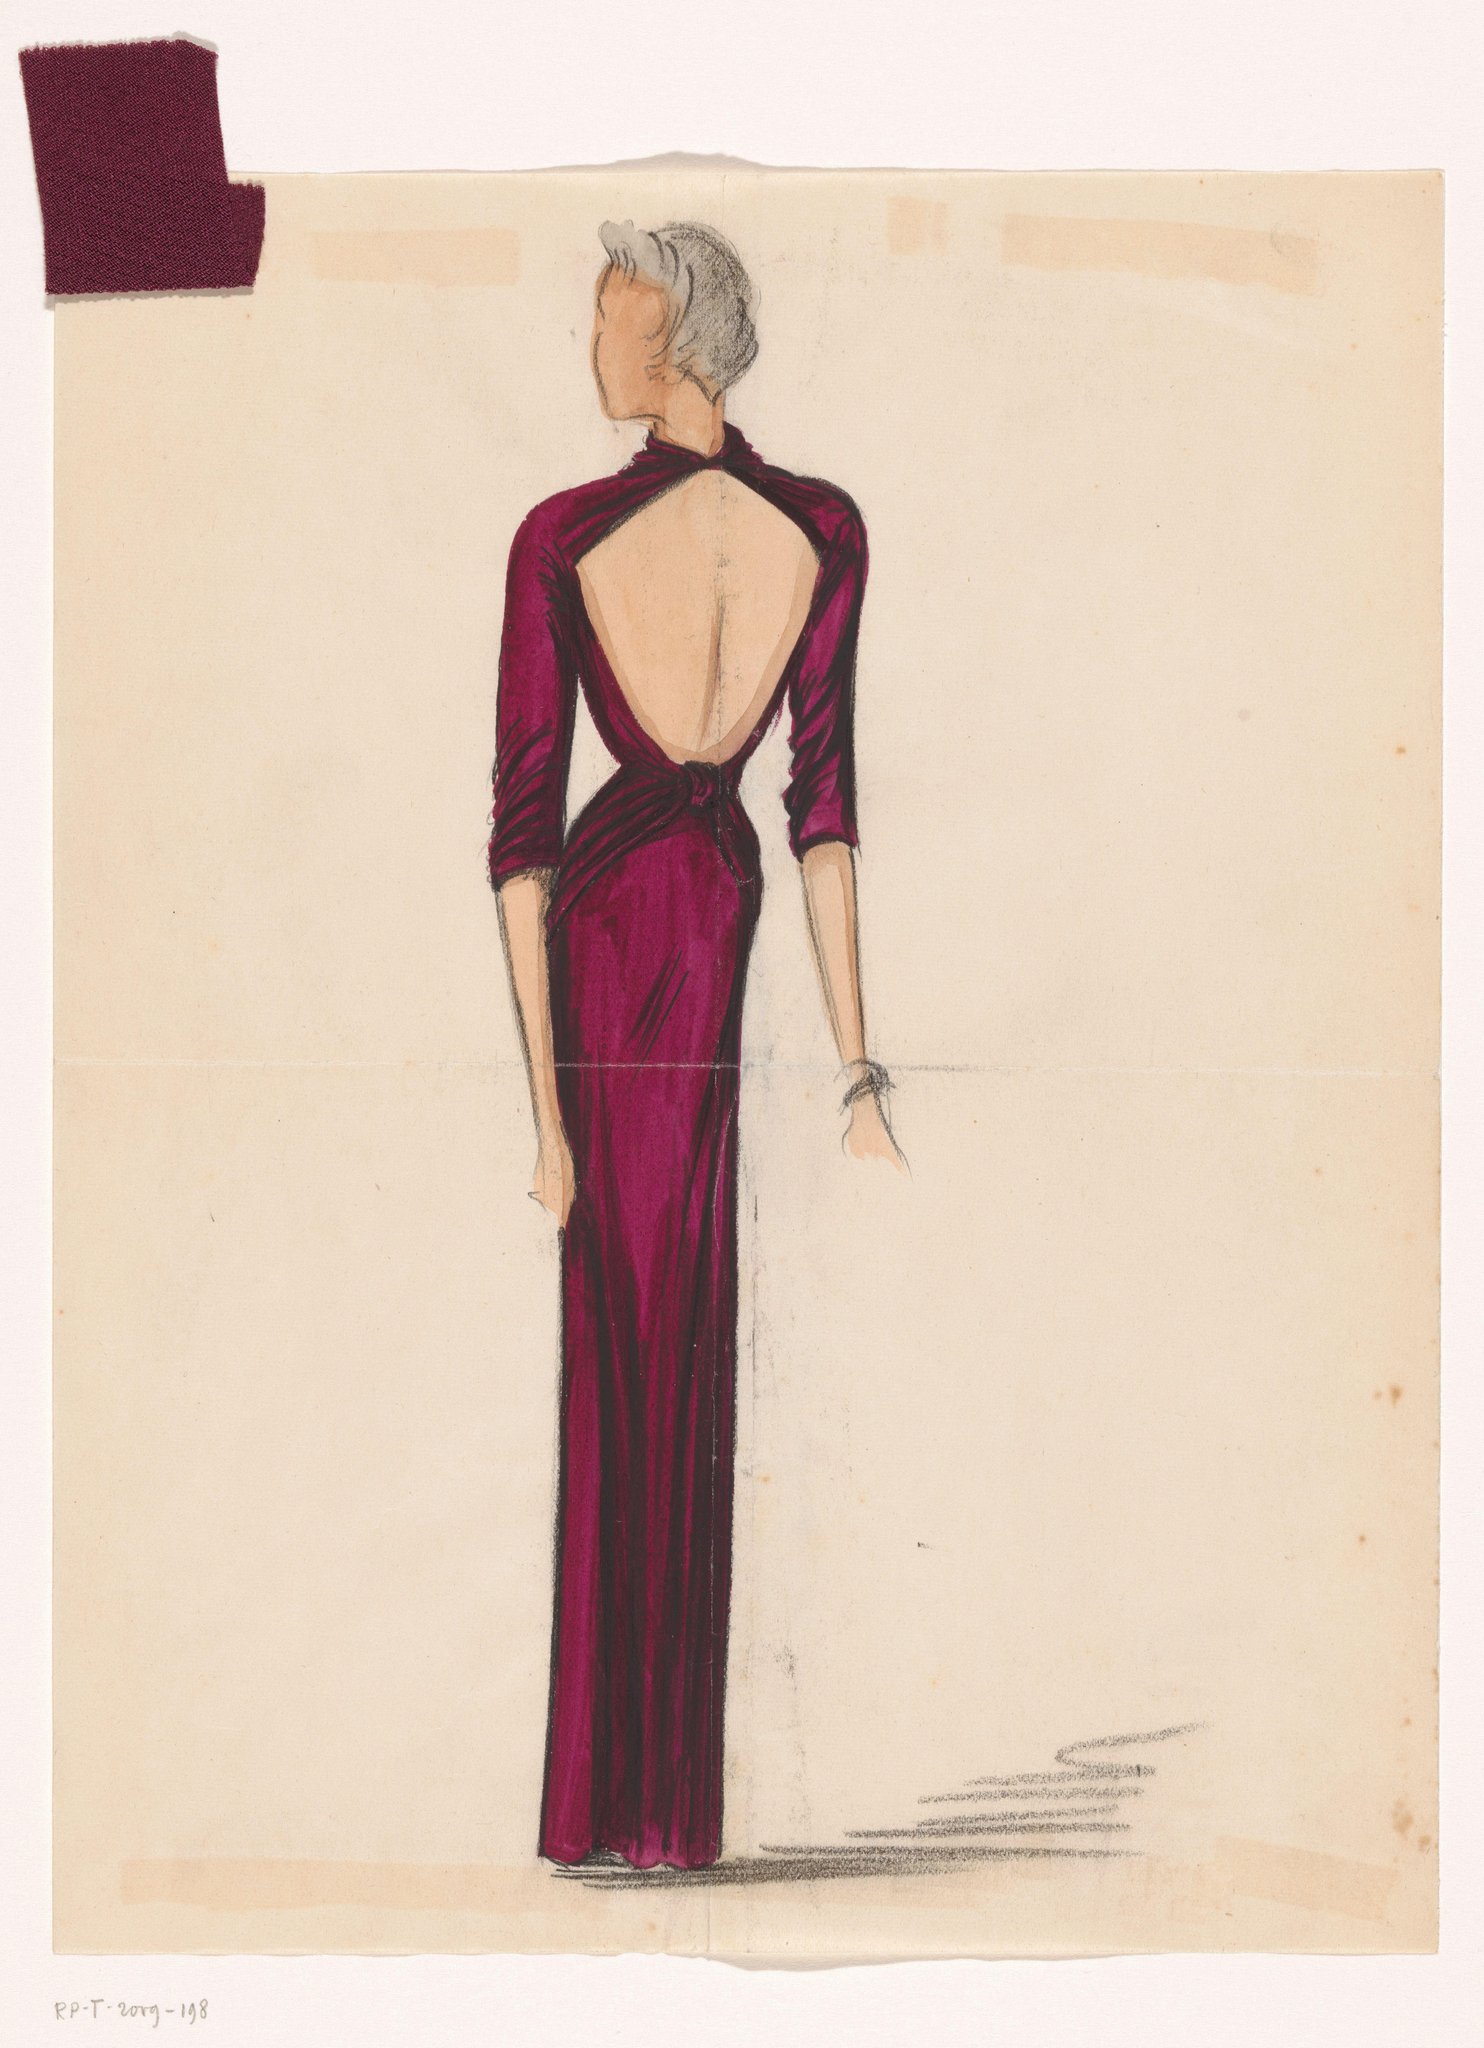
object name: fashion plate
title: Avondjapon van ALIX van bordeauxrode zijden jersey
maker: alix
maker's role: modeontwerper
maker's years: 1903-1993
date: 1938-1939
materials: paper, pencil, watercolor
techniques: brush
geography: paris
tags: dress, gown: evening dress (+ women's clothes), fashion plates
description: Avondjapon van bordeauxrode zijden jersey, toegeschreven aan Alix, later bekend al 'Madame Grès'. Sluik model met aansluitend lijf met halflange mouwen en open rug met geknoopte stof middenachter. Rok tot aan de grond. In de linker bovenhoek een staaltje bordeauxrode zijden jersey